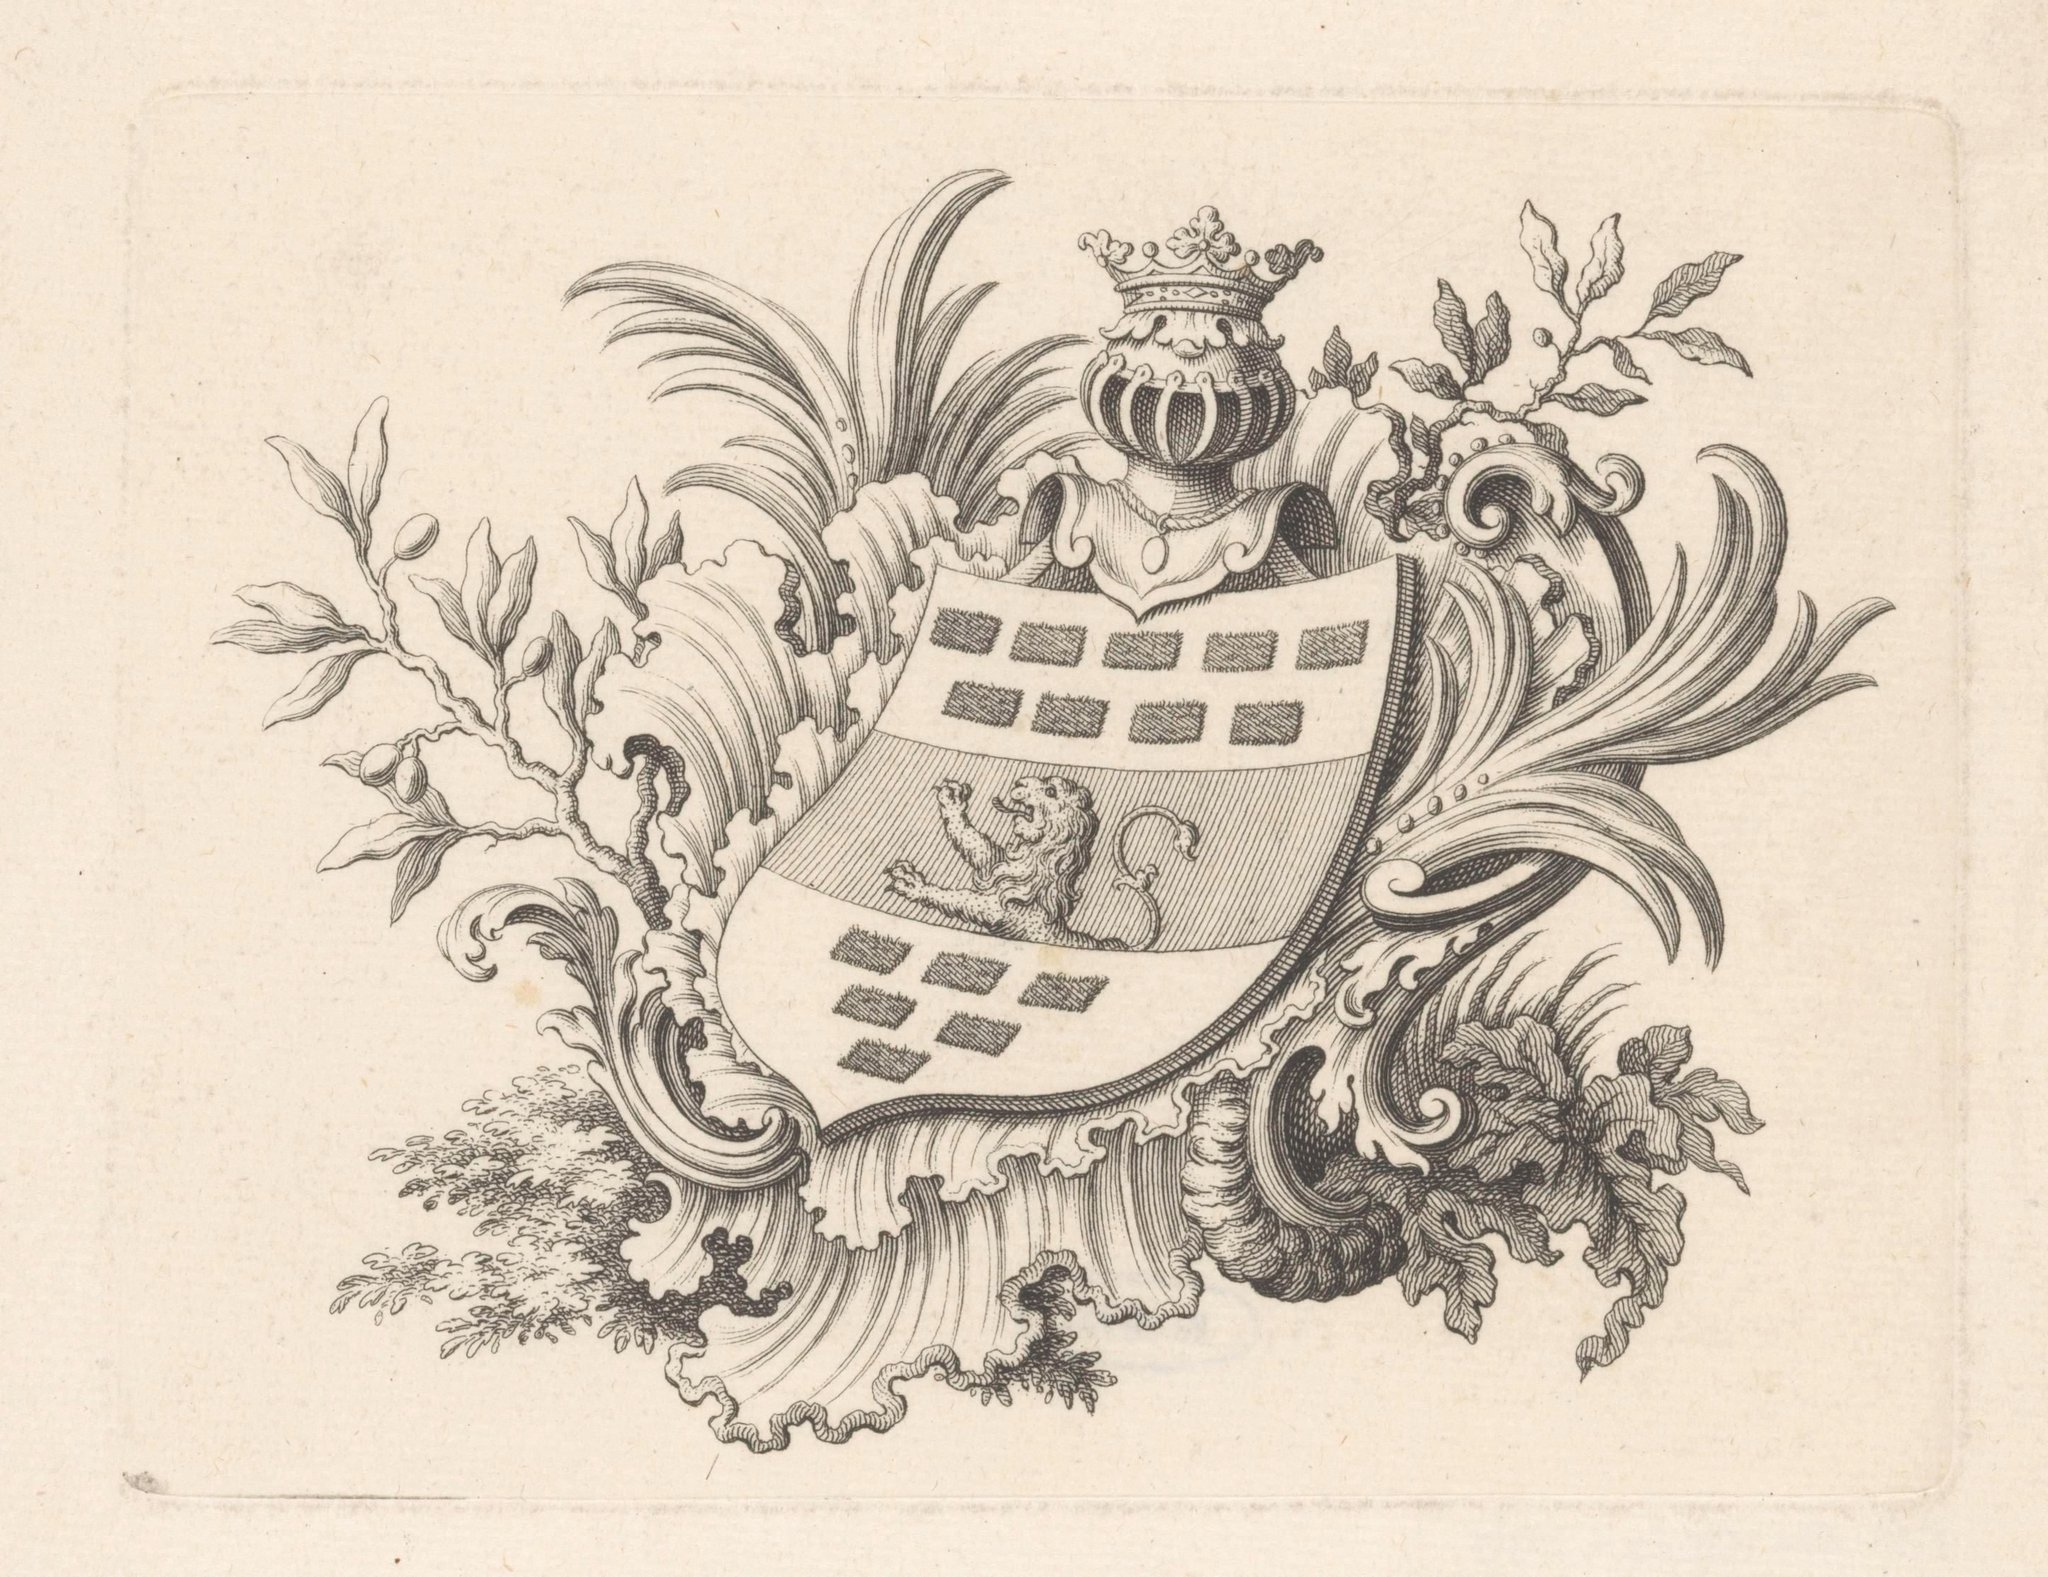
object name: print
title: Wapenschild van Oem van Wijngaarden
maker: Anonymous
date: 1600-1800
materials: paper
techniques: etching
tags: armorial bearing, heraldry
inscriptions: collector's mark: Lugt 2228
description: Wapenschild van het geslacht Oem van Wijngaarden, omgeven door bladmotieven en een helmteken.